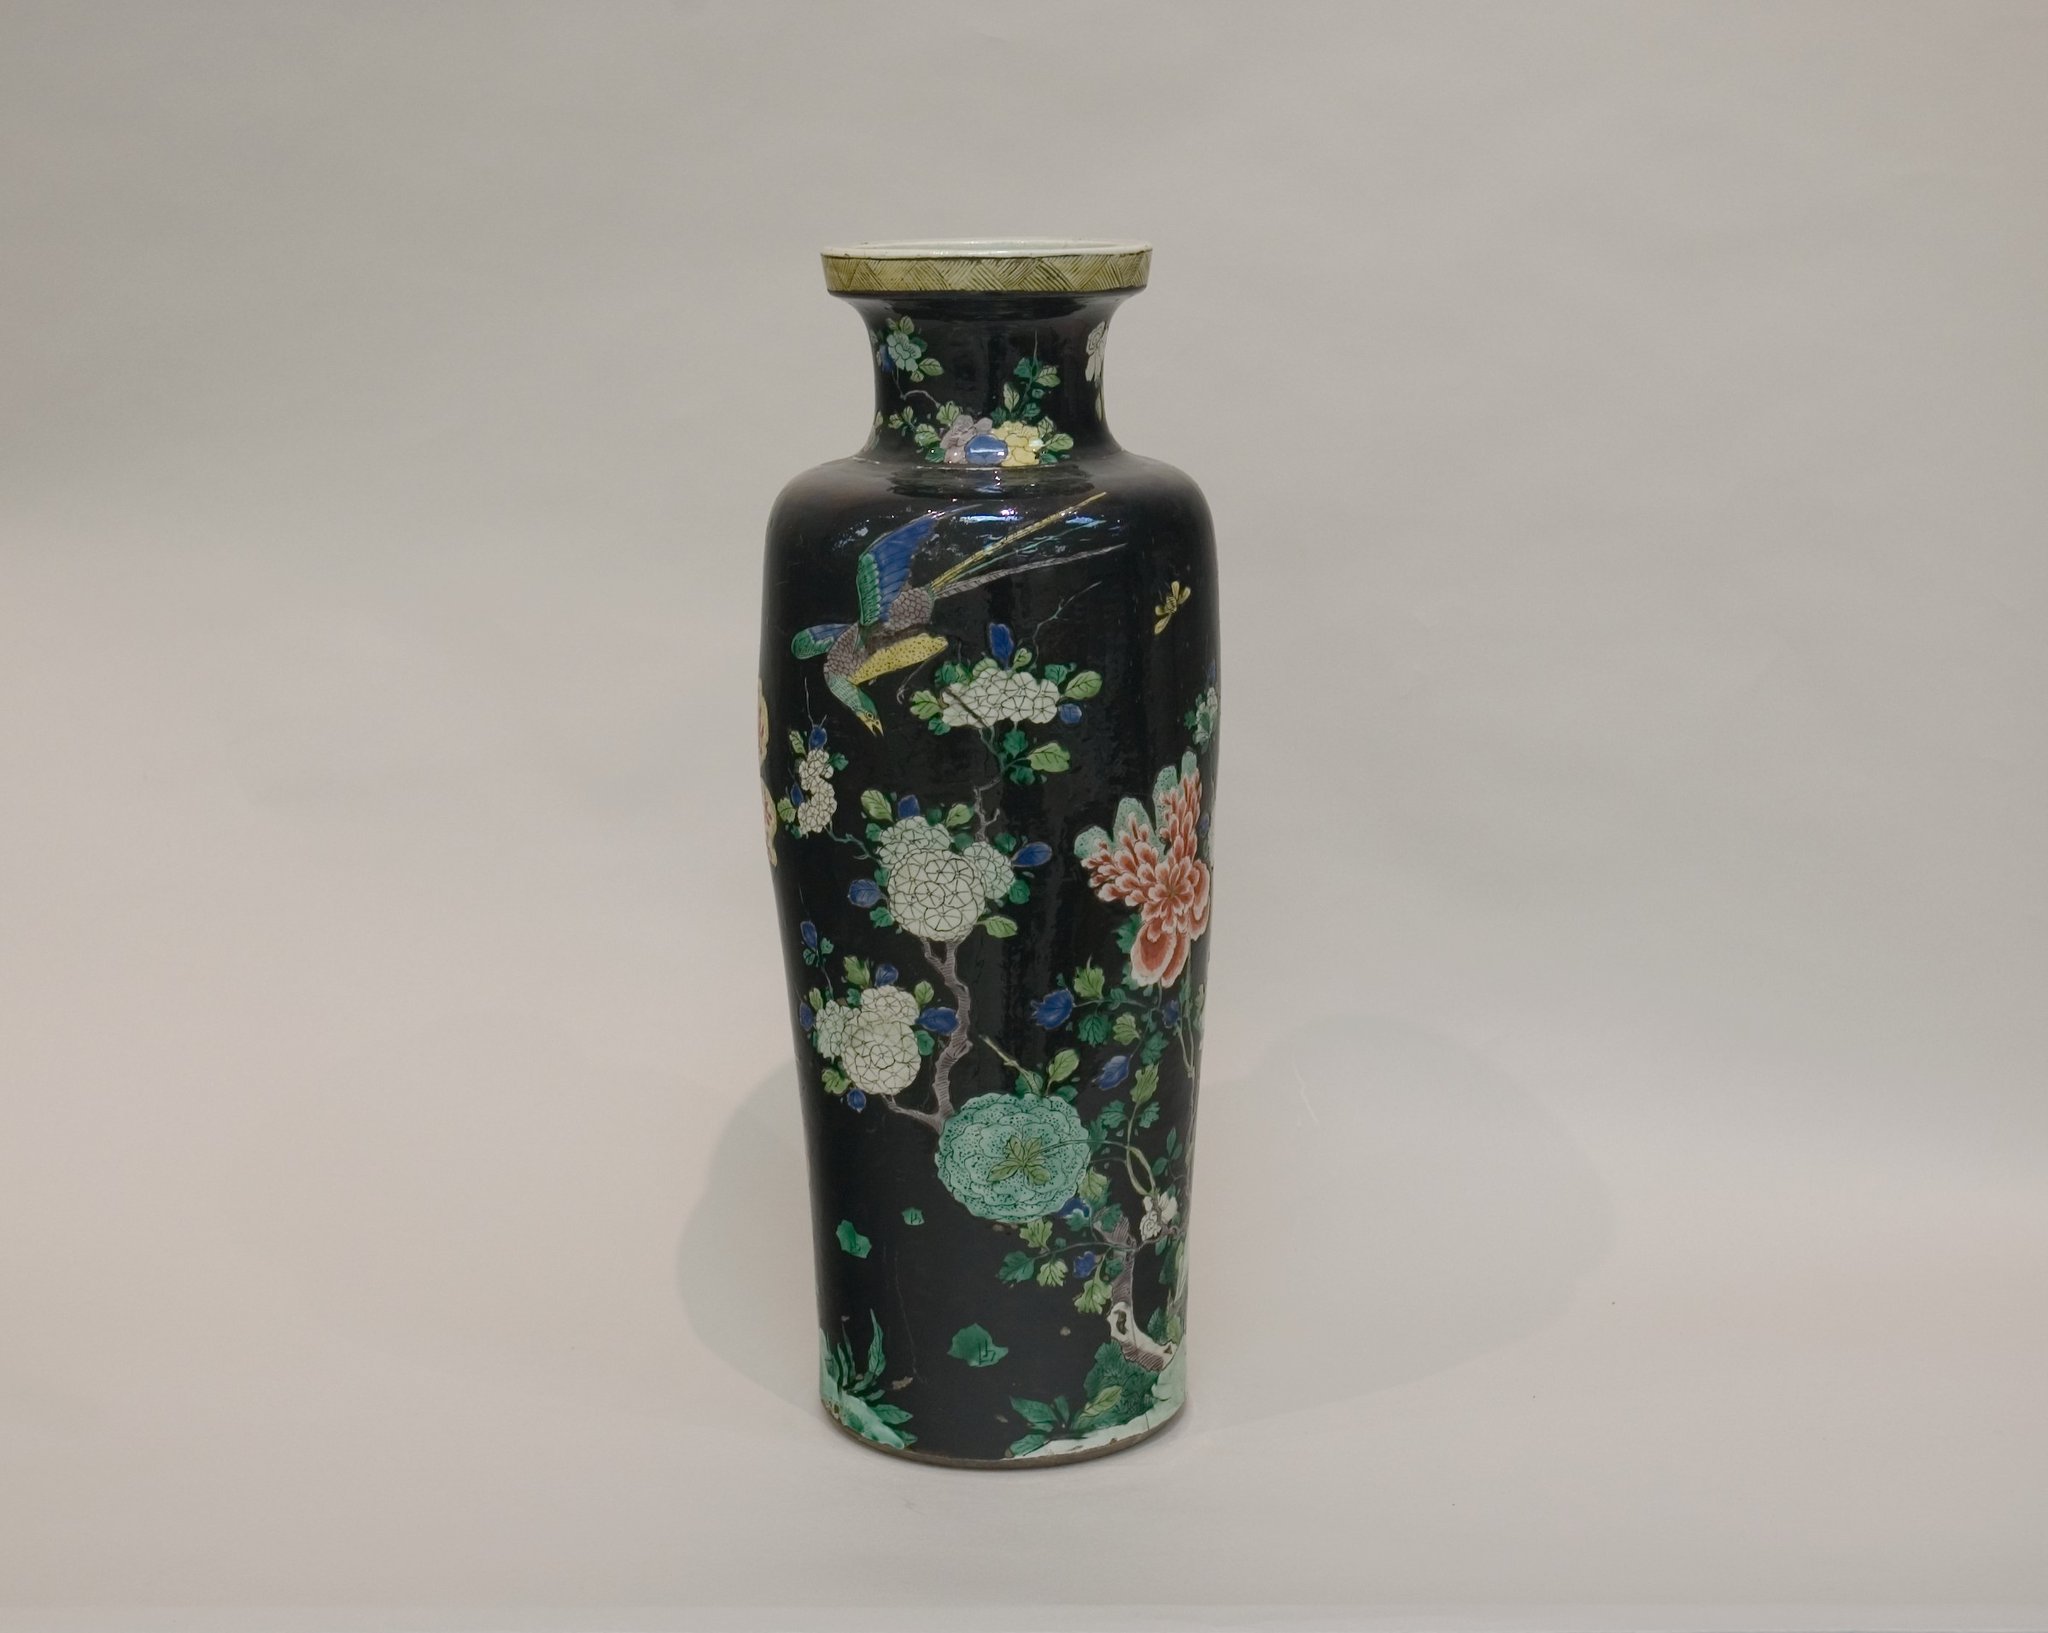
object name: vase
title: Vase with birds and flowers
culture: chinese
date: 1801-1900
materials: enamel, porcelain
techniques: overglaze, painting, polychrome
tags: birds,flowers,leaves